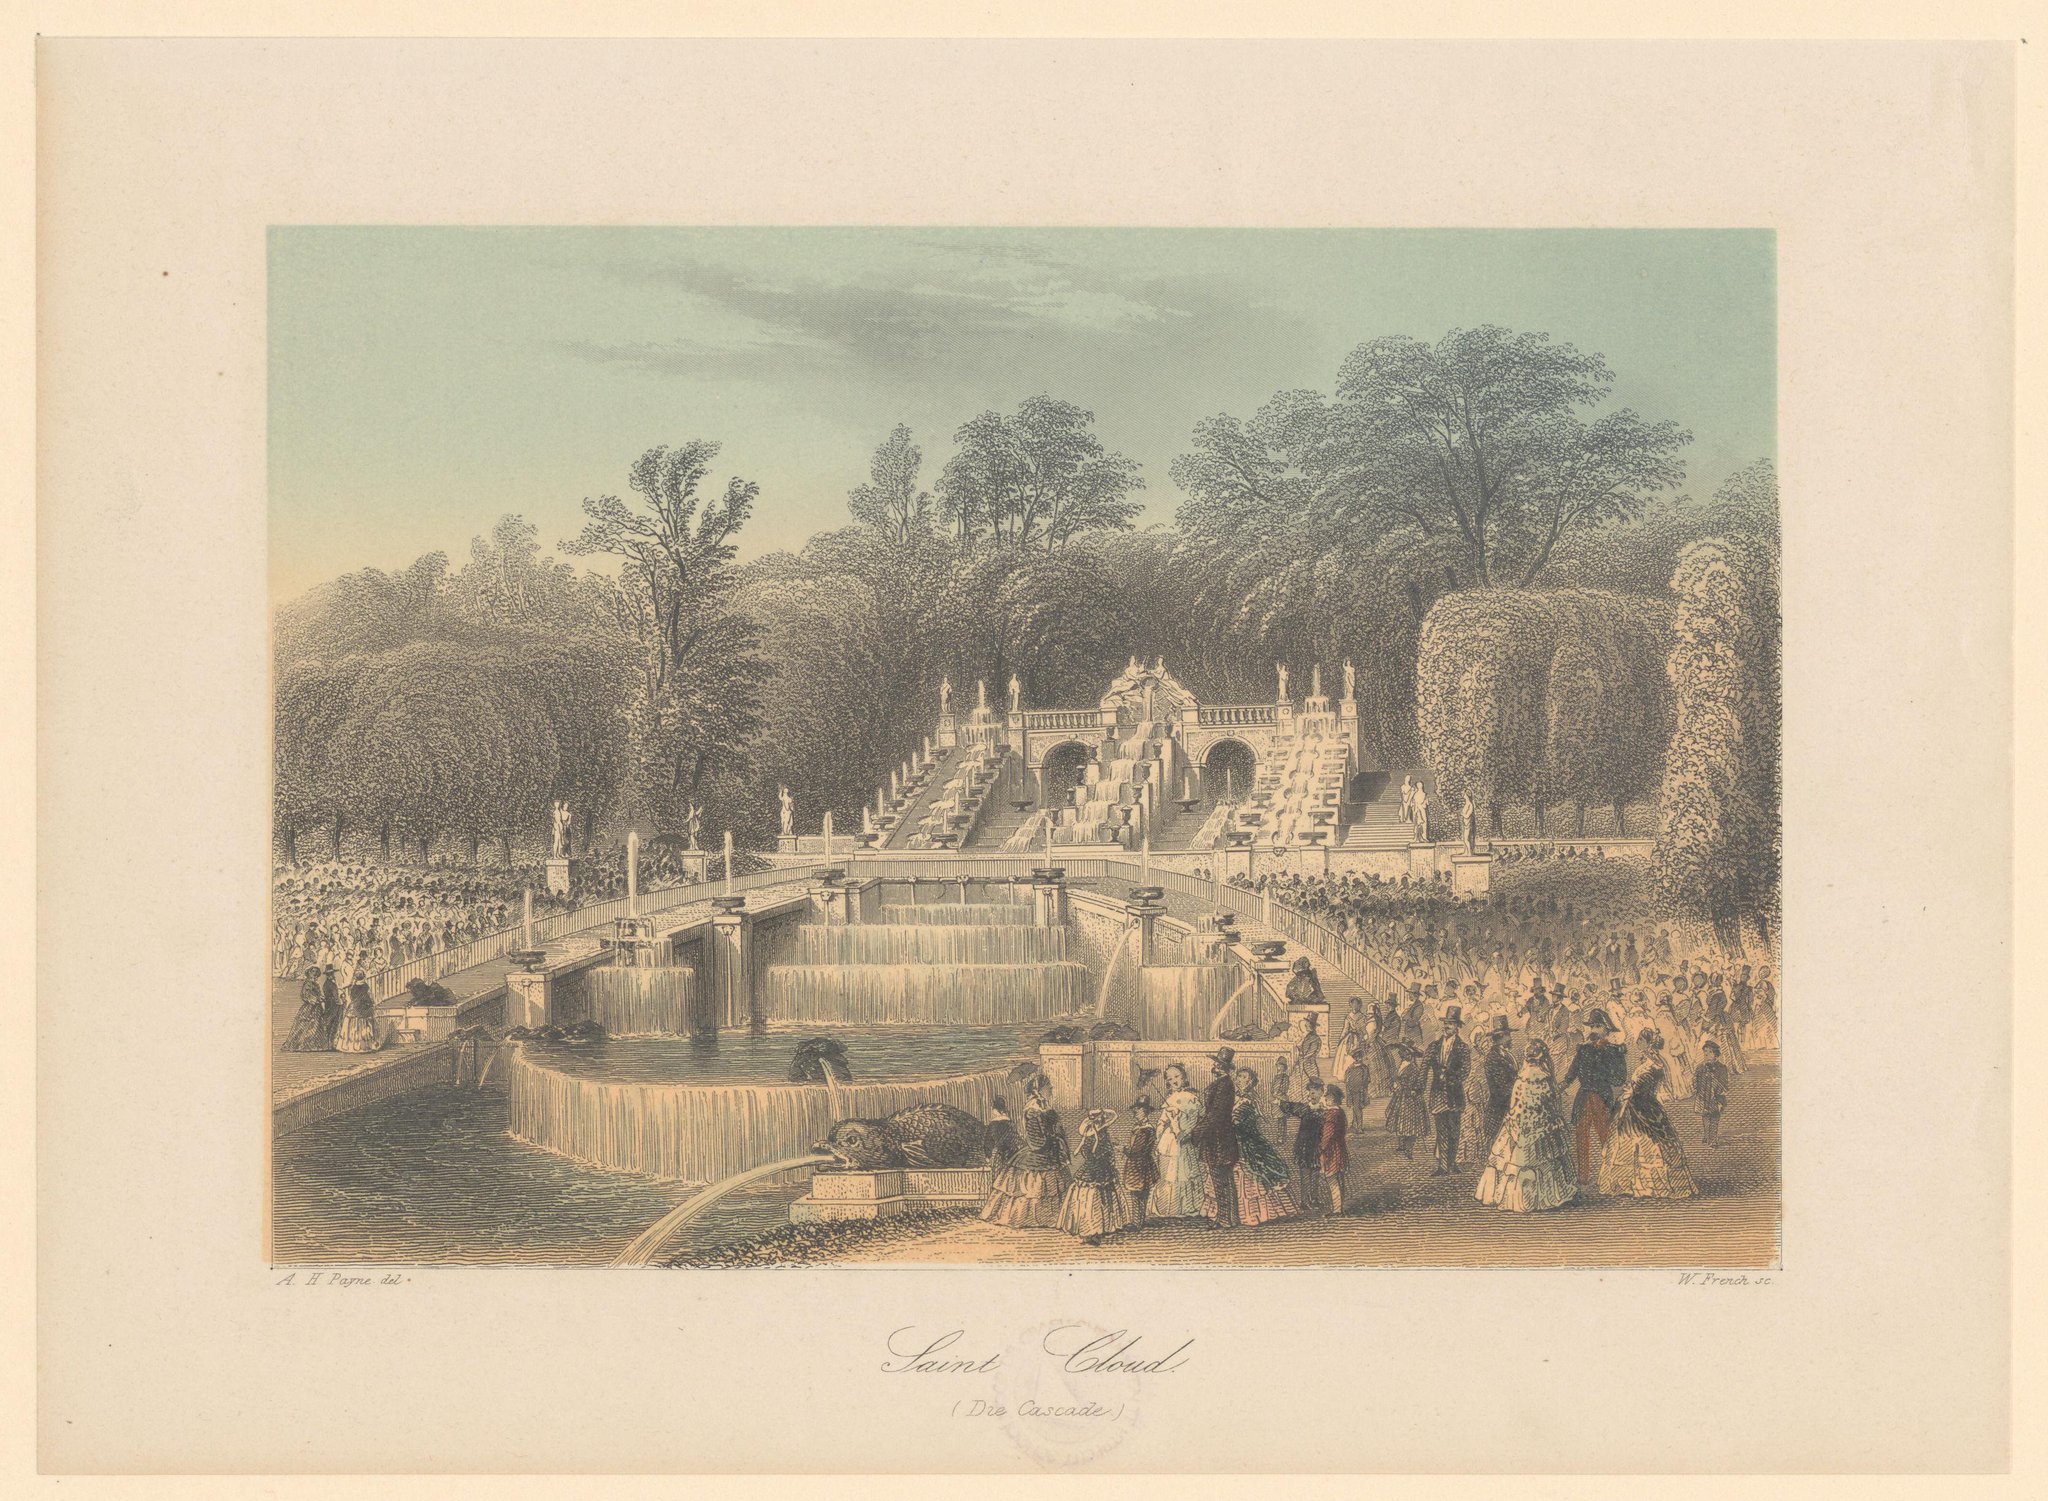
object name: print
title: Cascade in de tuin van het Kasteel Saint-Cloud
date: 1838-1898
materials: paper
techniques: intaglio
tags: garden cascade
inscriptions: collector's mark: Lugt 2228, collector's mark: ‘[...] Utrecht’